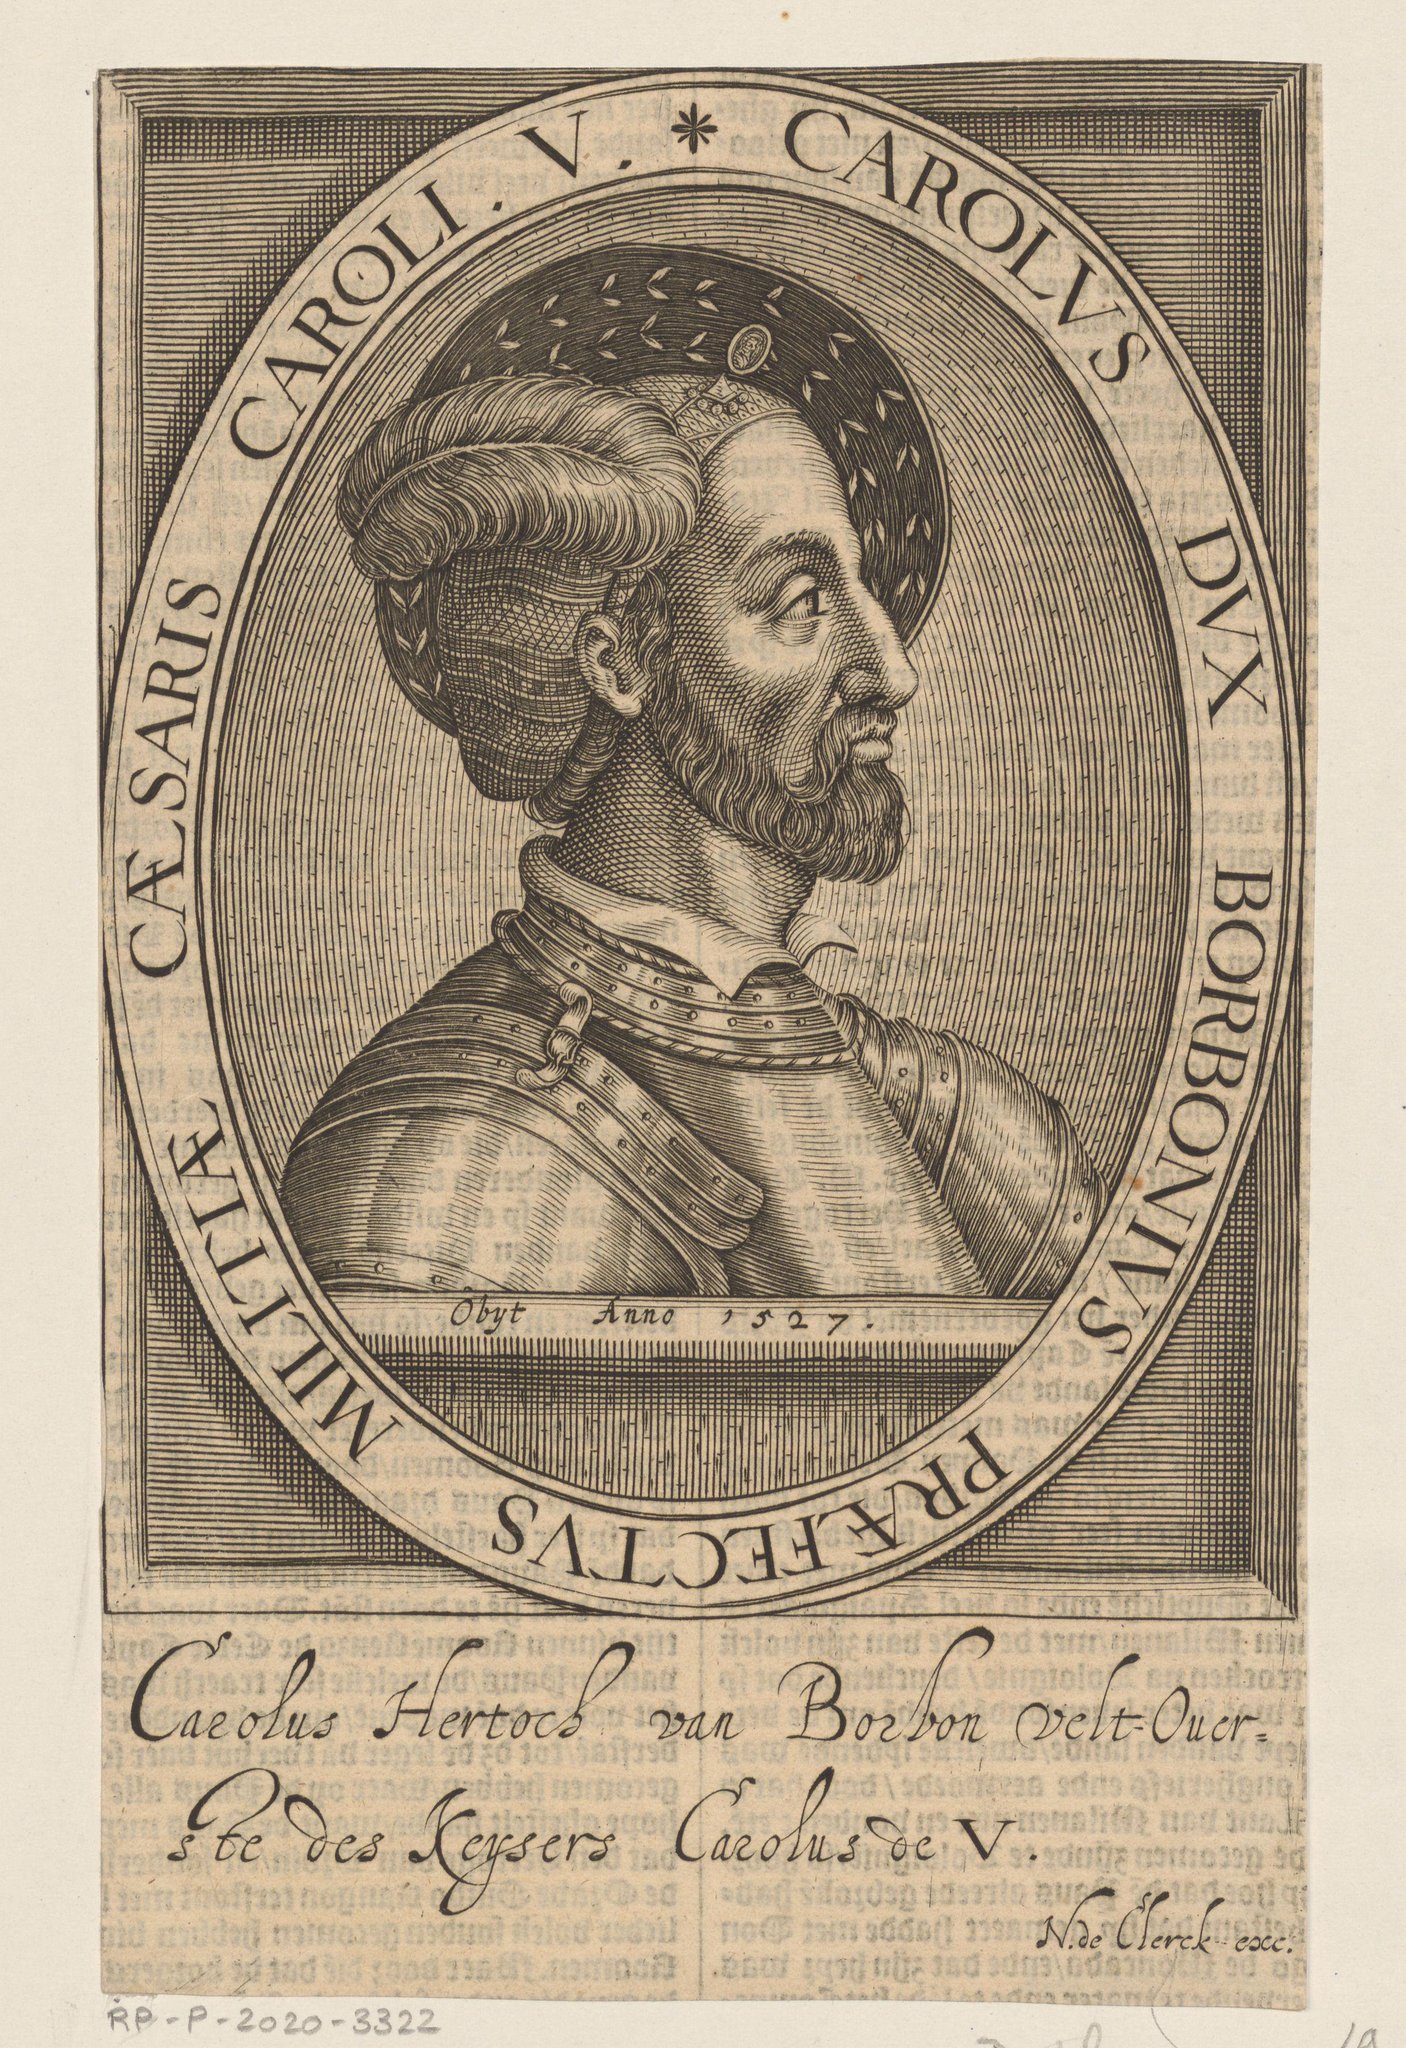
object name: print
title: Portret van Karel III, hertog van Bourbon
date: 1600-1649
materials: paper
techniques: engraving, letterpress printing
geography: delft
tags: armour, historical persons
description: Prent waarschijnlijk uit één van de edities van Emanuel van Meterens 'Nederlantsche historien'. Prent ook gebruikt in: Clerck, Nicolaes de. Tooneel der beroemder hertogen, princen, graven ende krygs-helden (...). Delft: Nicolaes de Clerck, 1617.